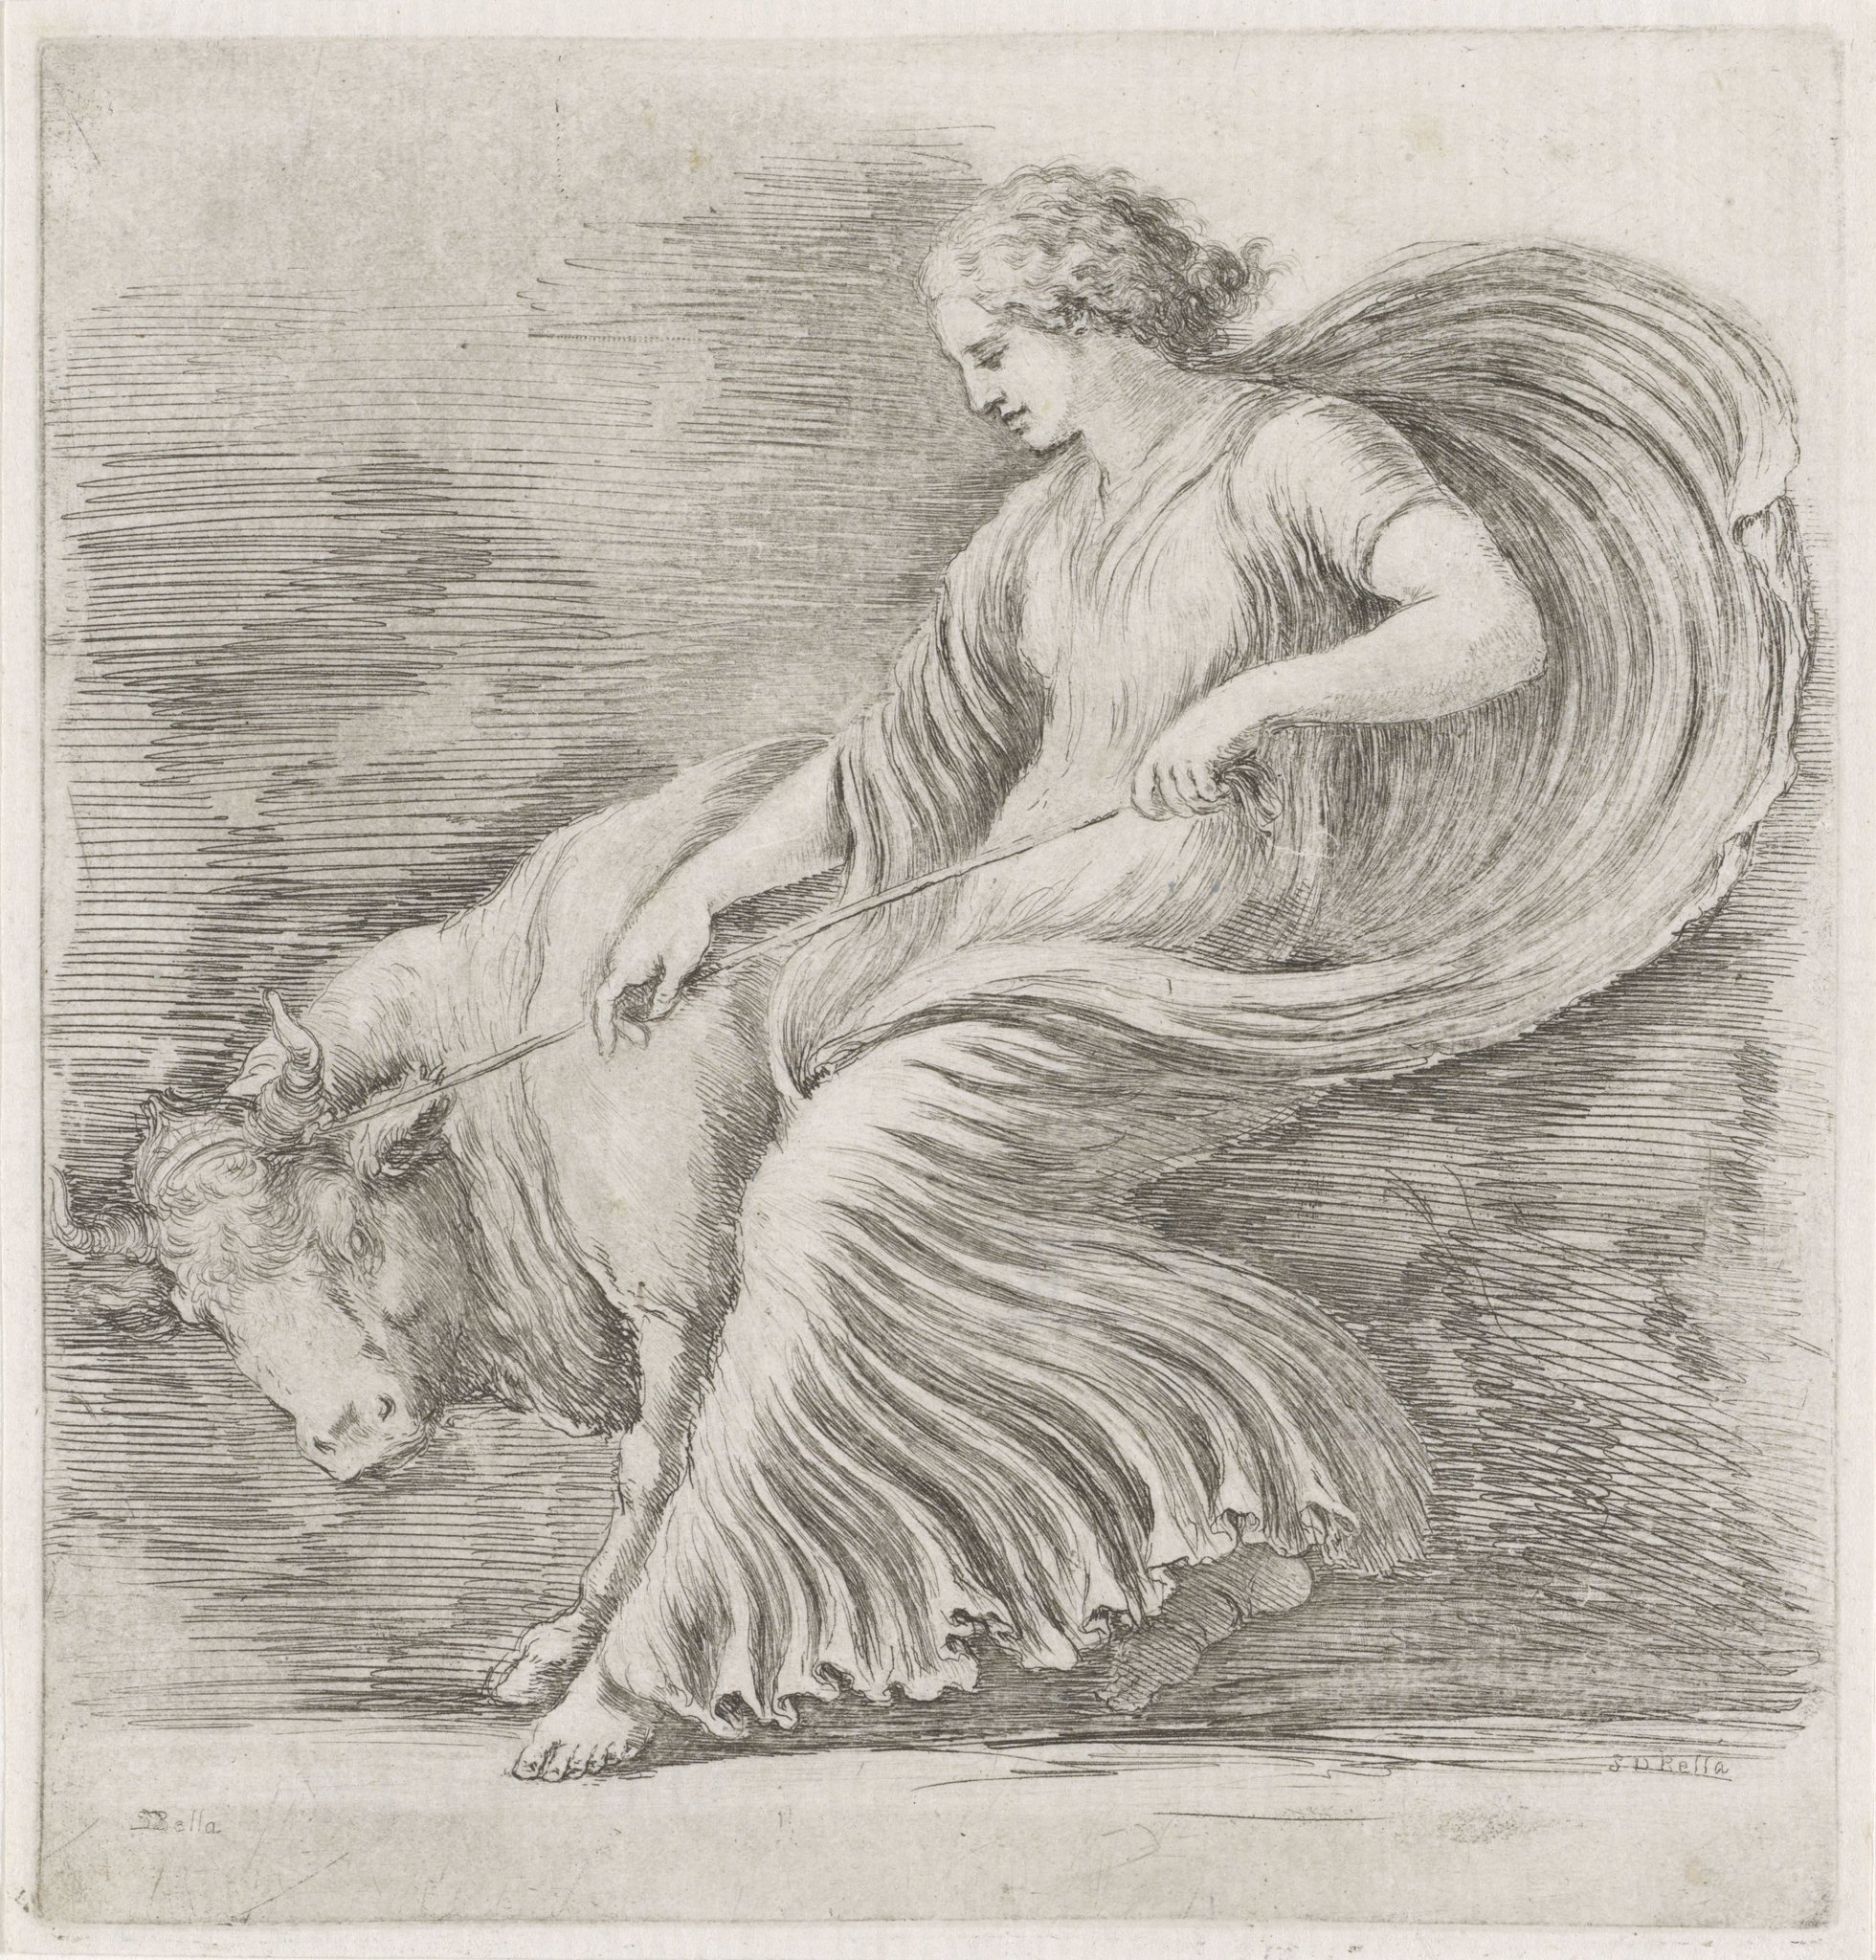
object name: print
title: Vrouw die stier tracht te bedwingen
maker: stefano della bella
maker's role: draughtsman, print maker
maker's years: 1610-1664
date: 1620-1664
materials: paper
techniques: etching, intaglio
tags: bull, adult woman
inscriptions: collector's mark: Lugt 240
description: Naar een antiek reliëf. Getekende voorstudie wordt bewaard in de Galleria degli Uffizi te Florence (inv. nr. 14818 F).